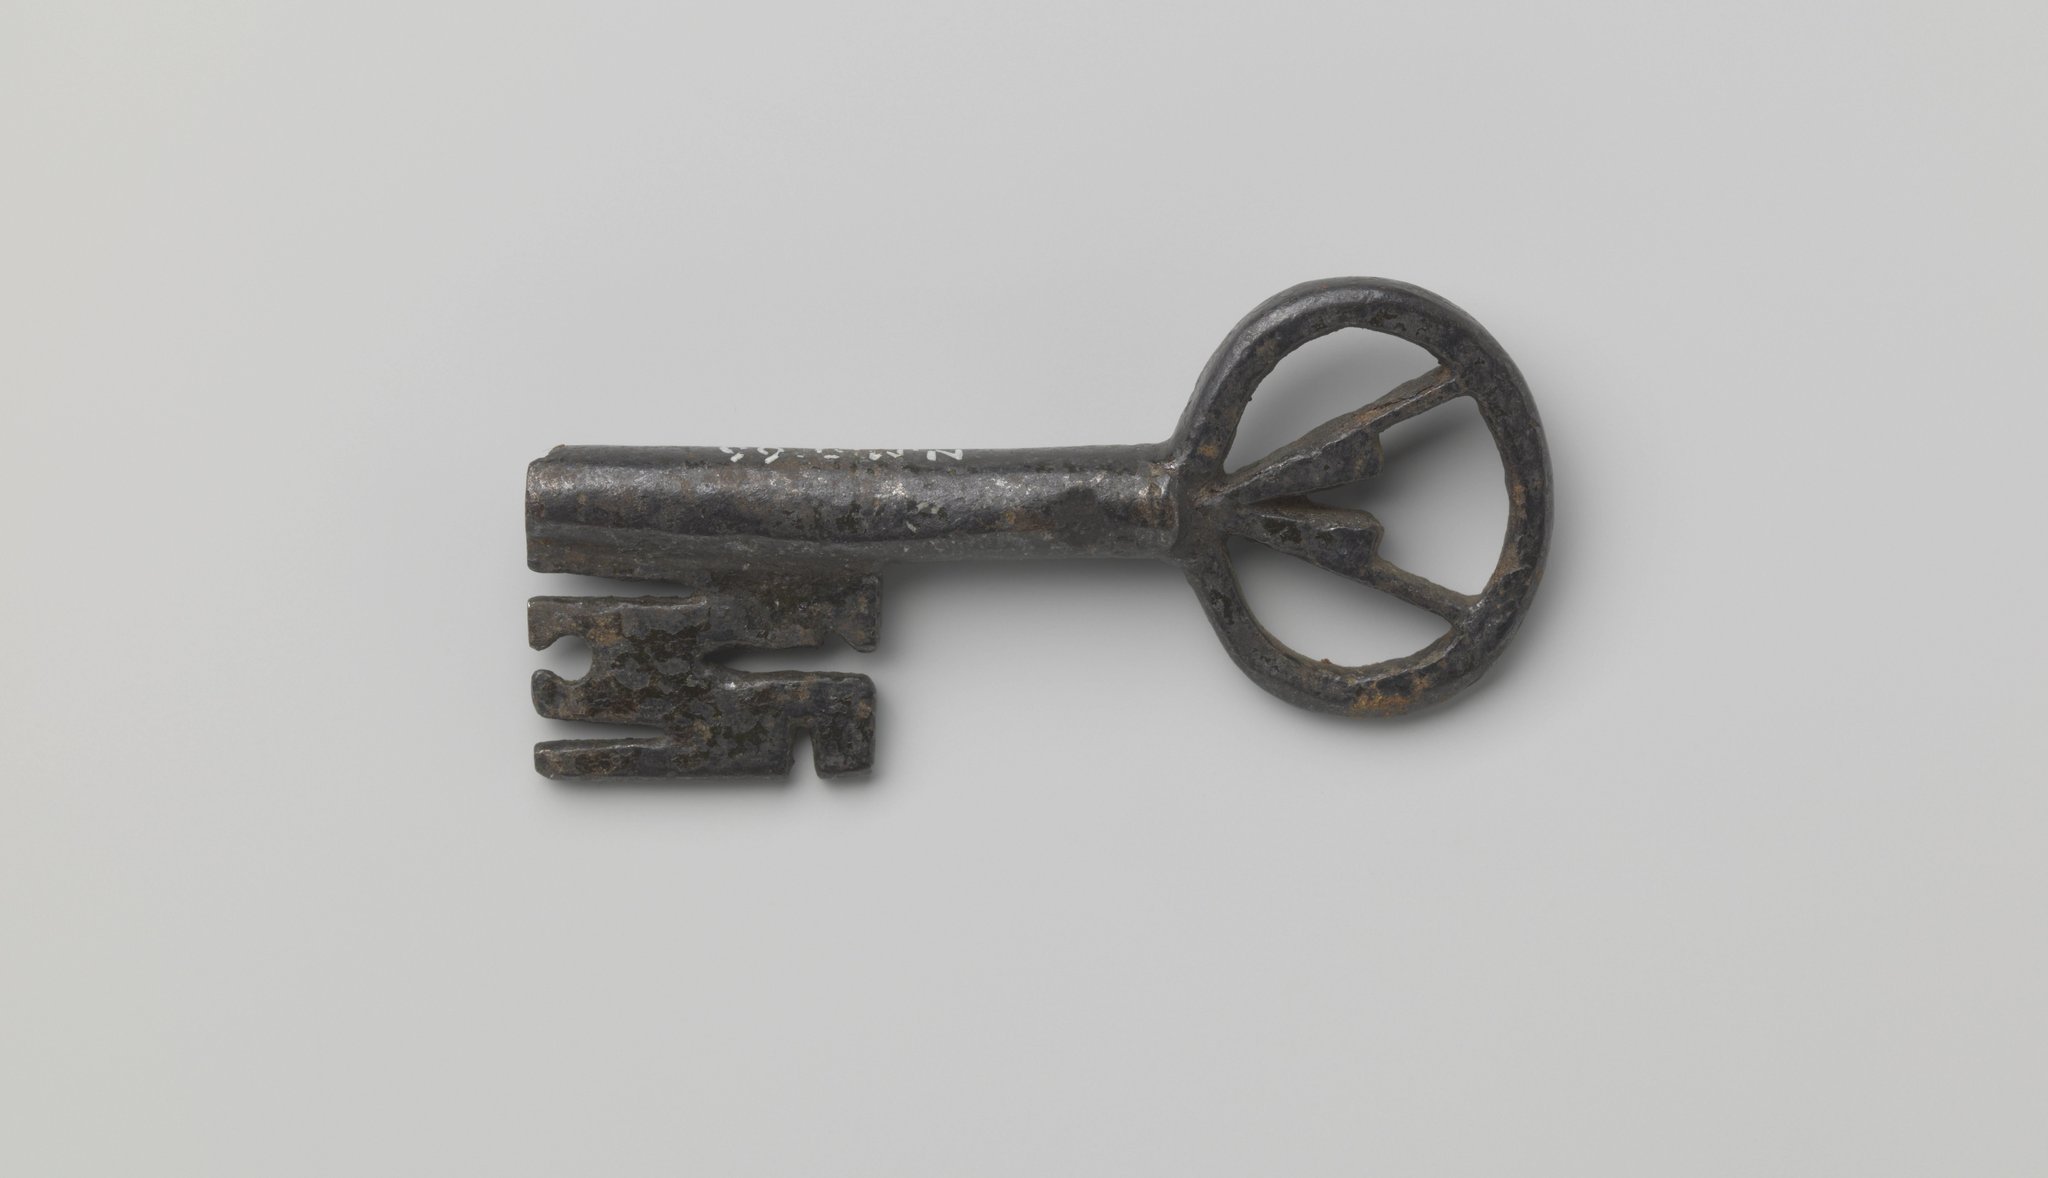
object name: key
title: Sleutel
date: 1400-1950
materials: iron